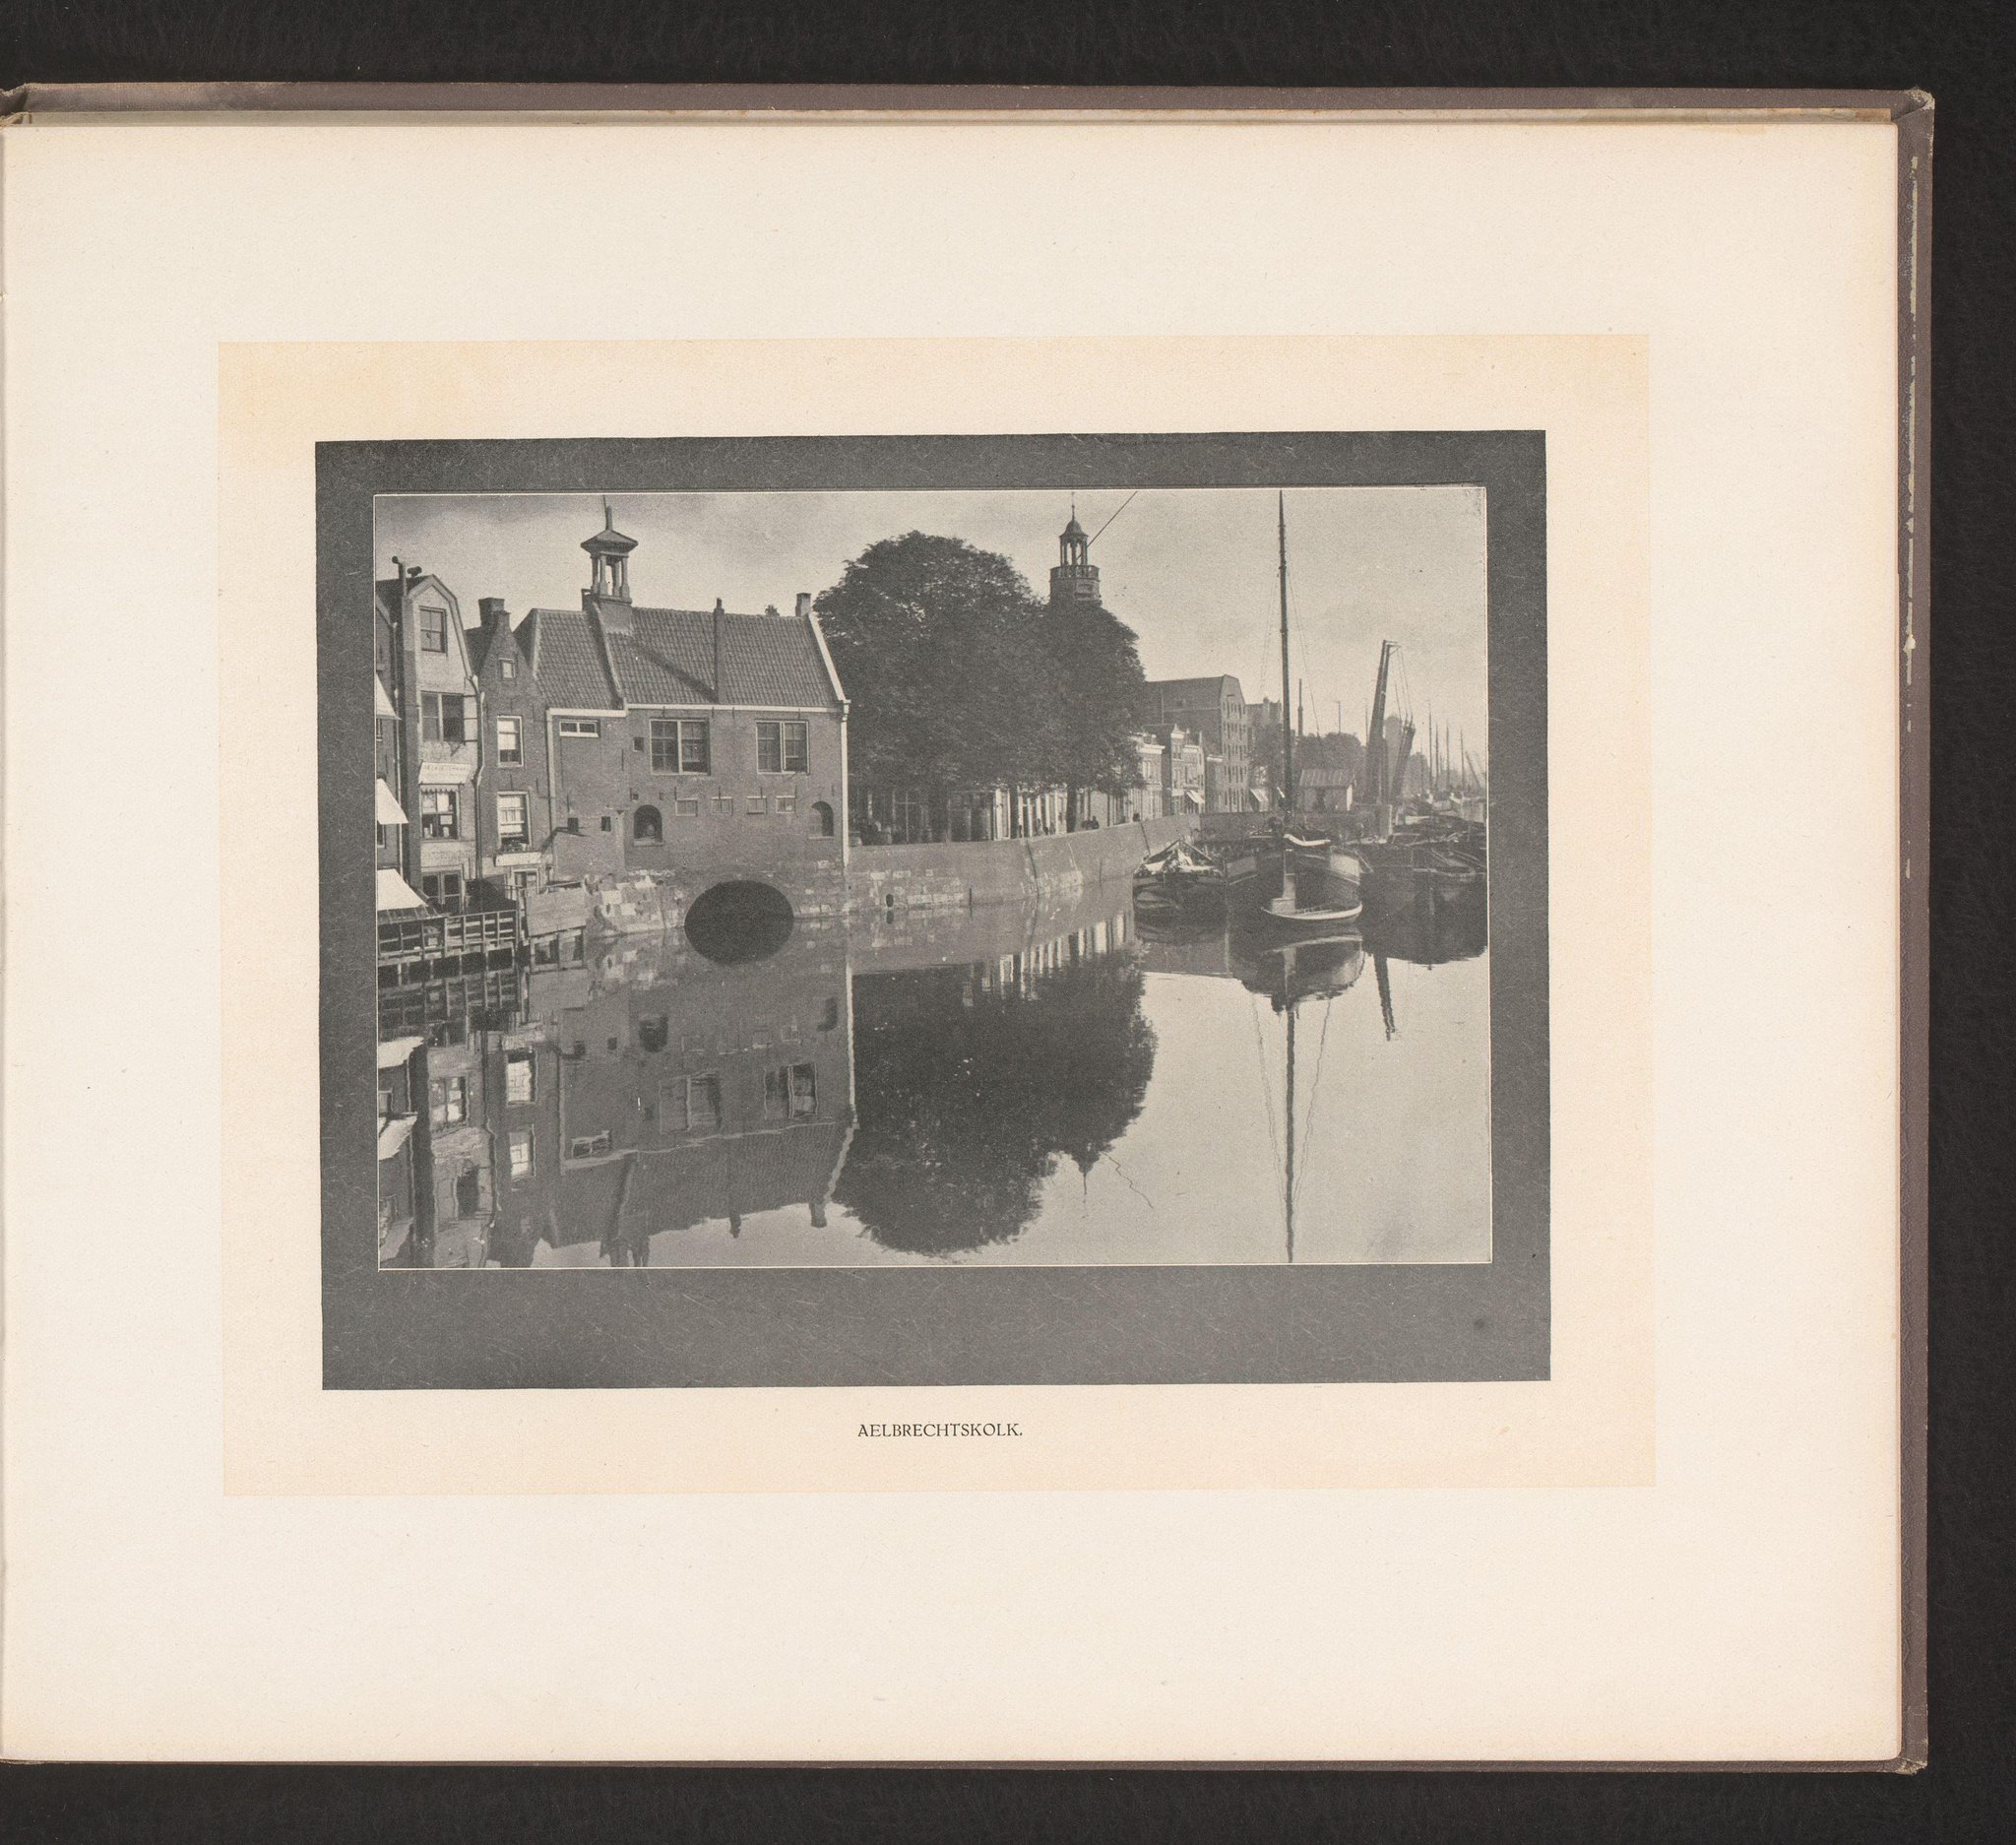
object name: photomechanical print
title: Gezicht op de Aelbrechtskolk te Rotterdam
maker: Anonymous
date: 1908-1913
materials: paper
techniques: autotype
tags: urban housing, canals, waters (in city) (+ city(-scape) with figures, staffage), rotterdam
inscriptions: inscription: ‘Aelbrechtskolk.’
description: Deze prent maakt deel uit van een album.